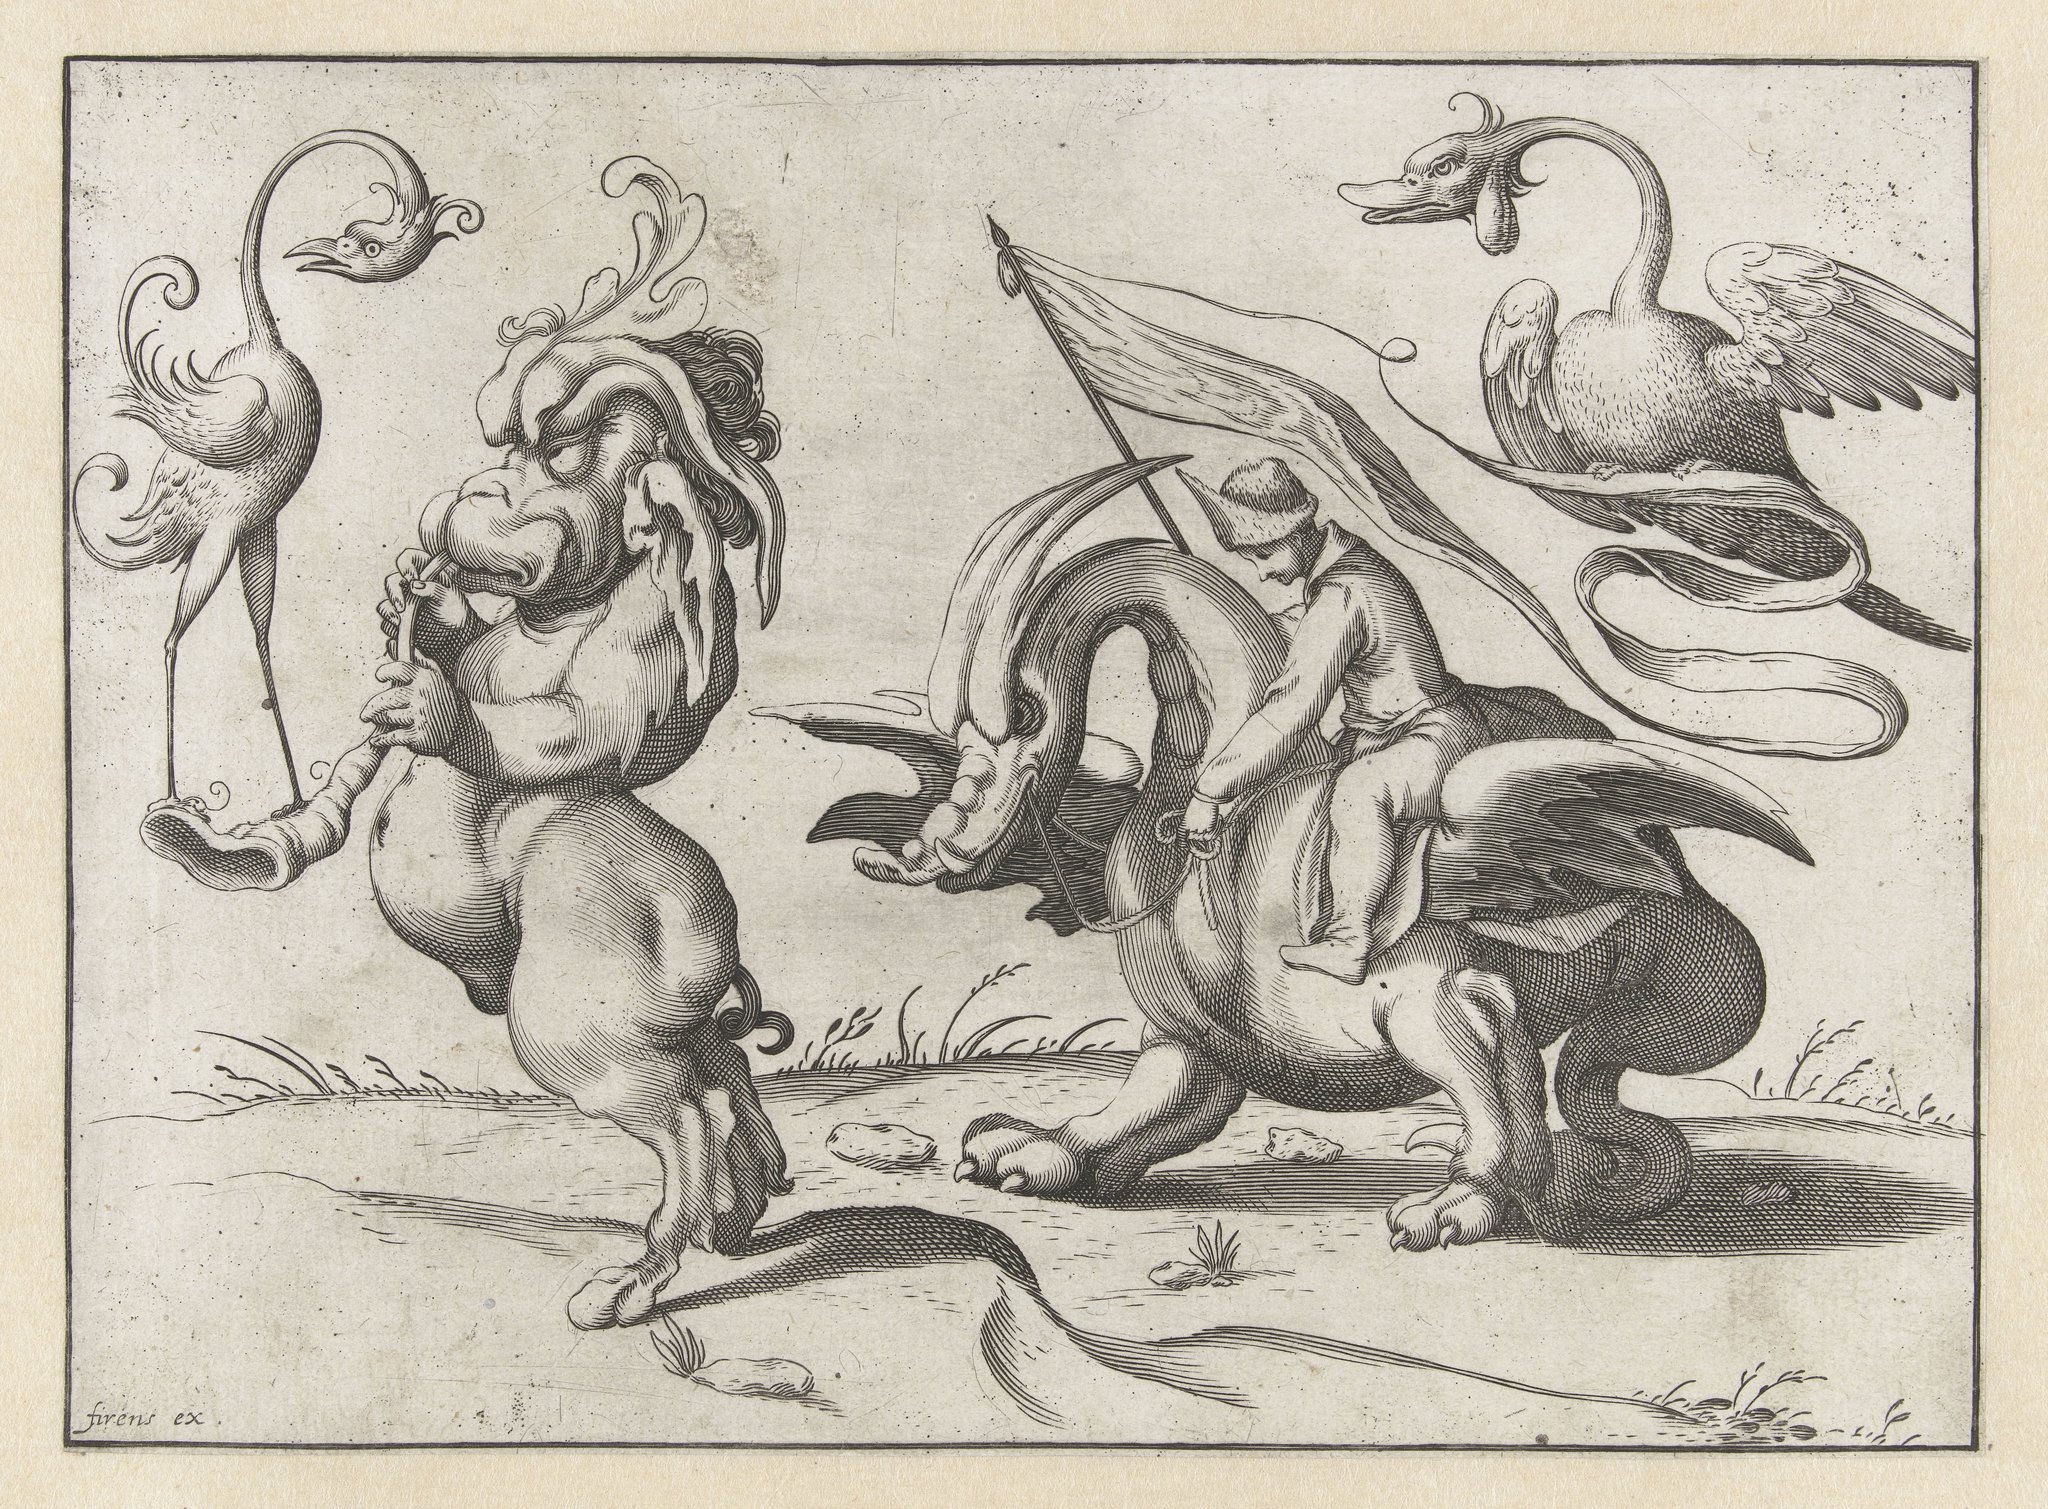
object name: print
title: Reeks van Groteske Figuren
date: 1604-1616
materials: paper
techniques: engraving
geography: paris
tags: ornament ~ grotesque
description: Monster met trompet waarop een soort kraanvogel staat. Rechts staat een ruiter met een vaandel op een draak. Op het vaandel zit een zwaan. No. 3 serie van 7 bladen.